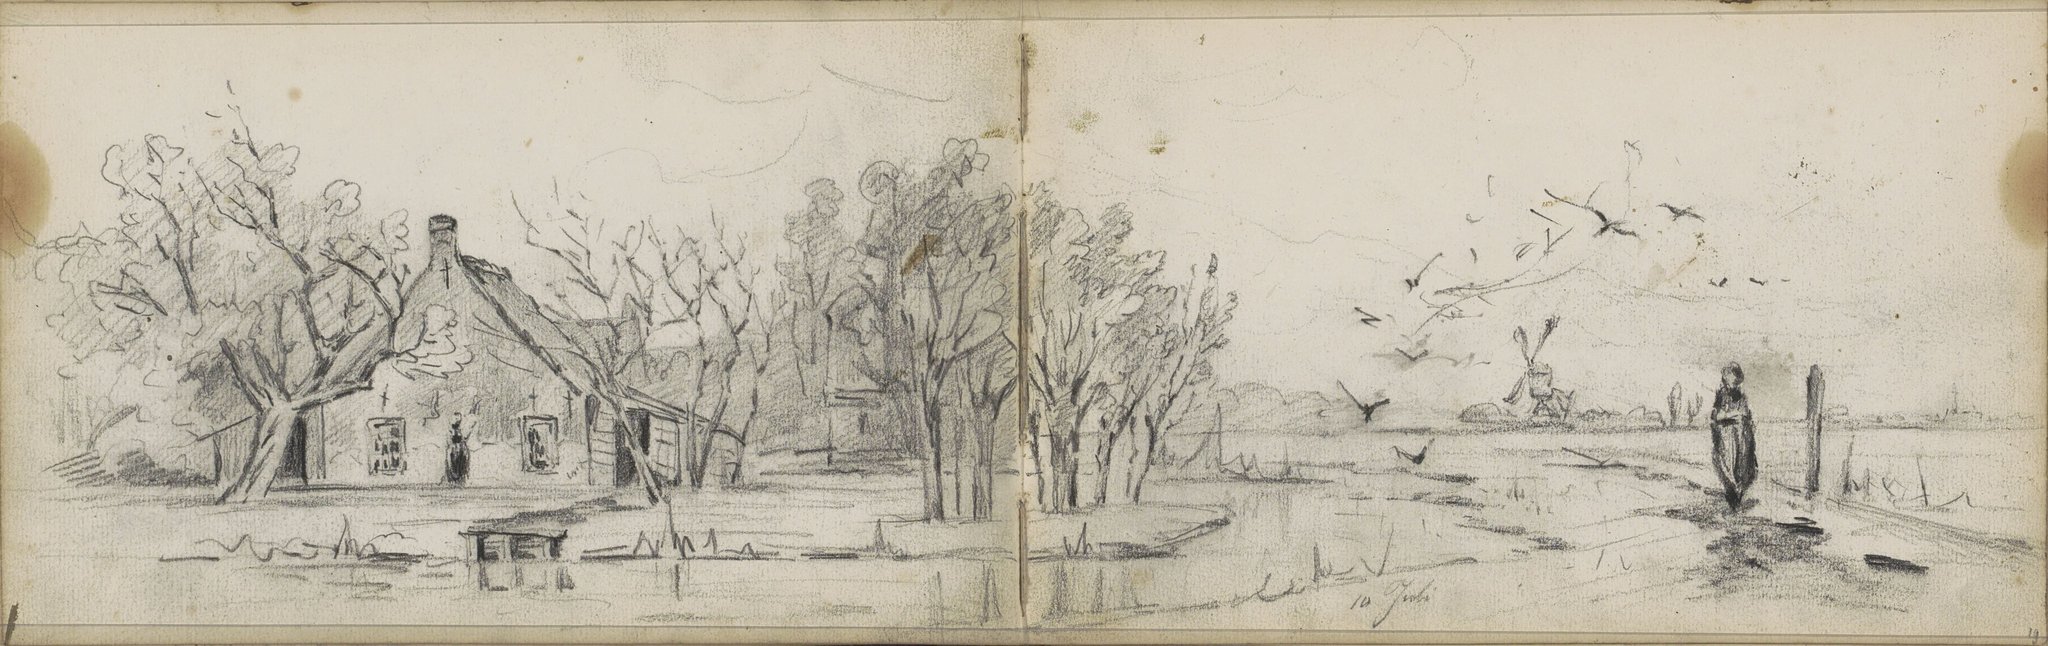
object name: sketchbook leaf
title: Polderlandschap met een rivier, molen en boerderij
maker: willem cornelis rip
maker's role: draughtsman, painter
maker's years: 1856-1922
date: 1807-1877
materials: paper, pencil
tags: windmill in landscape, landscapes with waters, waterscapes, seascapes (in the temperate zone) (+ landscape with figures, staffage), farm (building)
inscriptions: date: ‘10 Juli 77’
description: Blad 18 verso en 19 recto uit een schetsboek met 41 bladen.